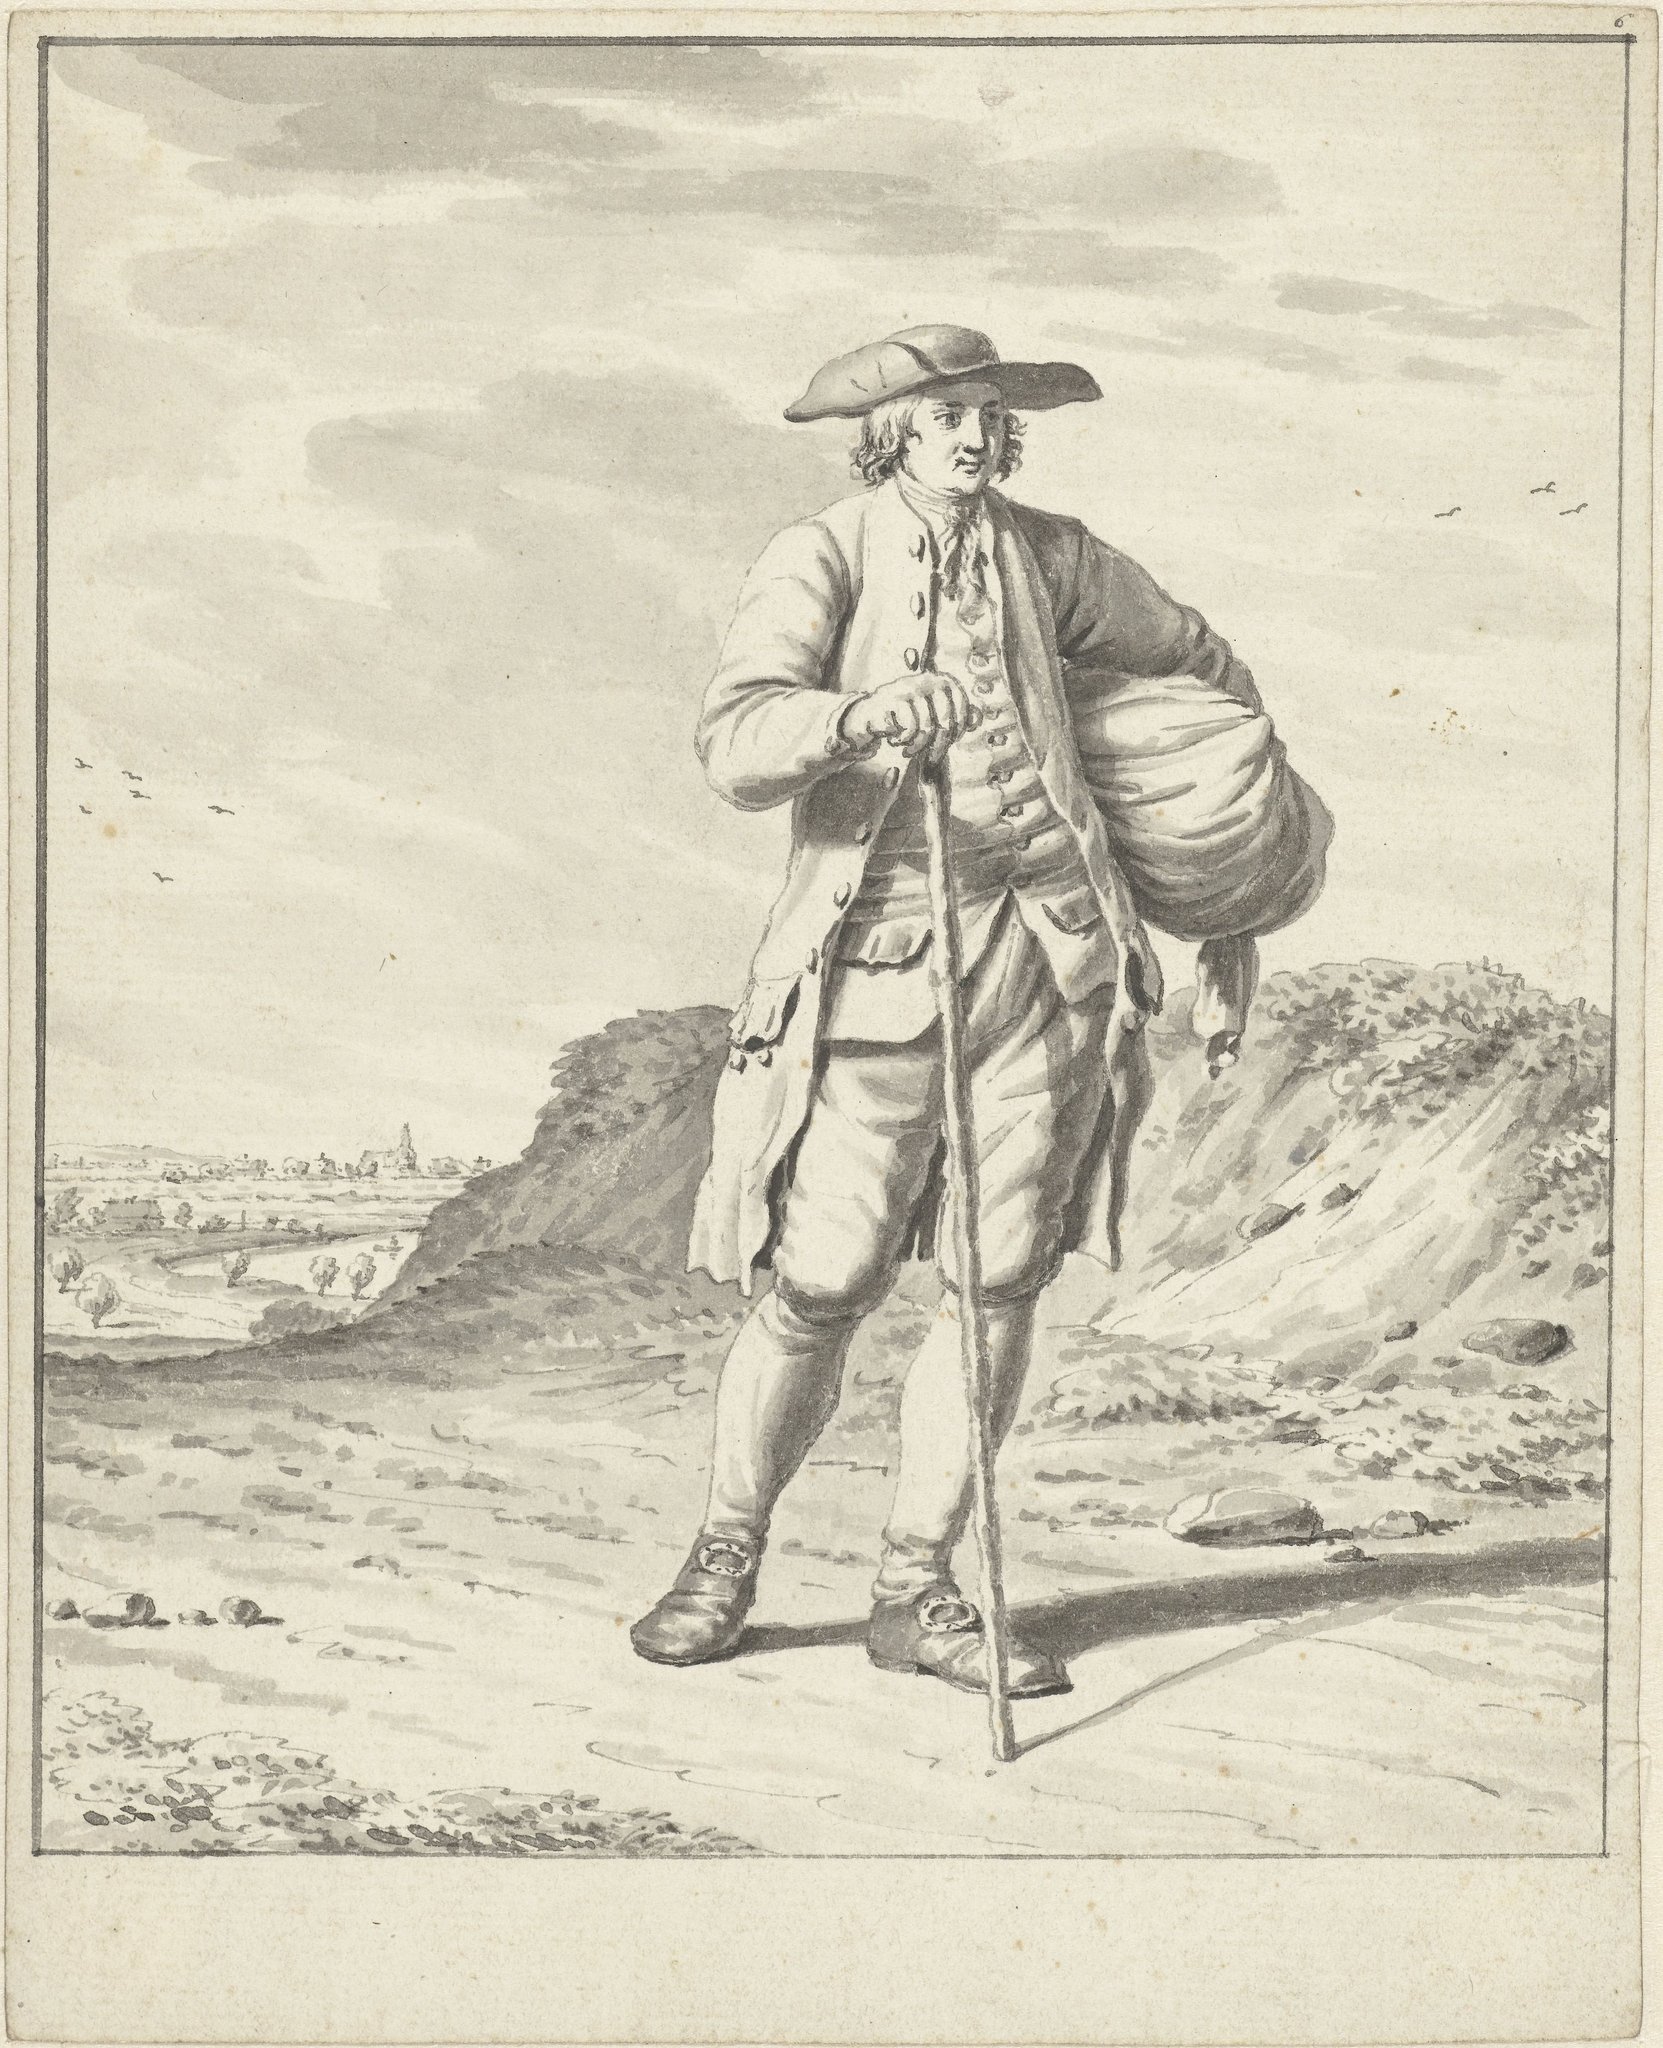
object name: drawing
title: Reiziger met steek op het hoofd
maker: jordanus hoorn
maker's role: draughtsman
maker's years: 1753-1833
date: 1763-1833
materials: chalk, ink, paper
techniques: brush, pen